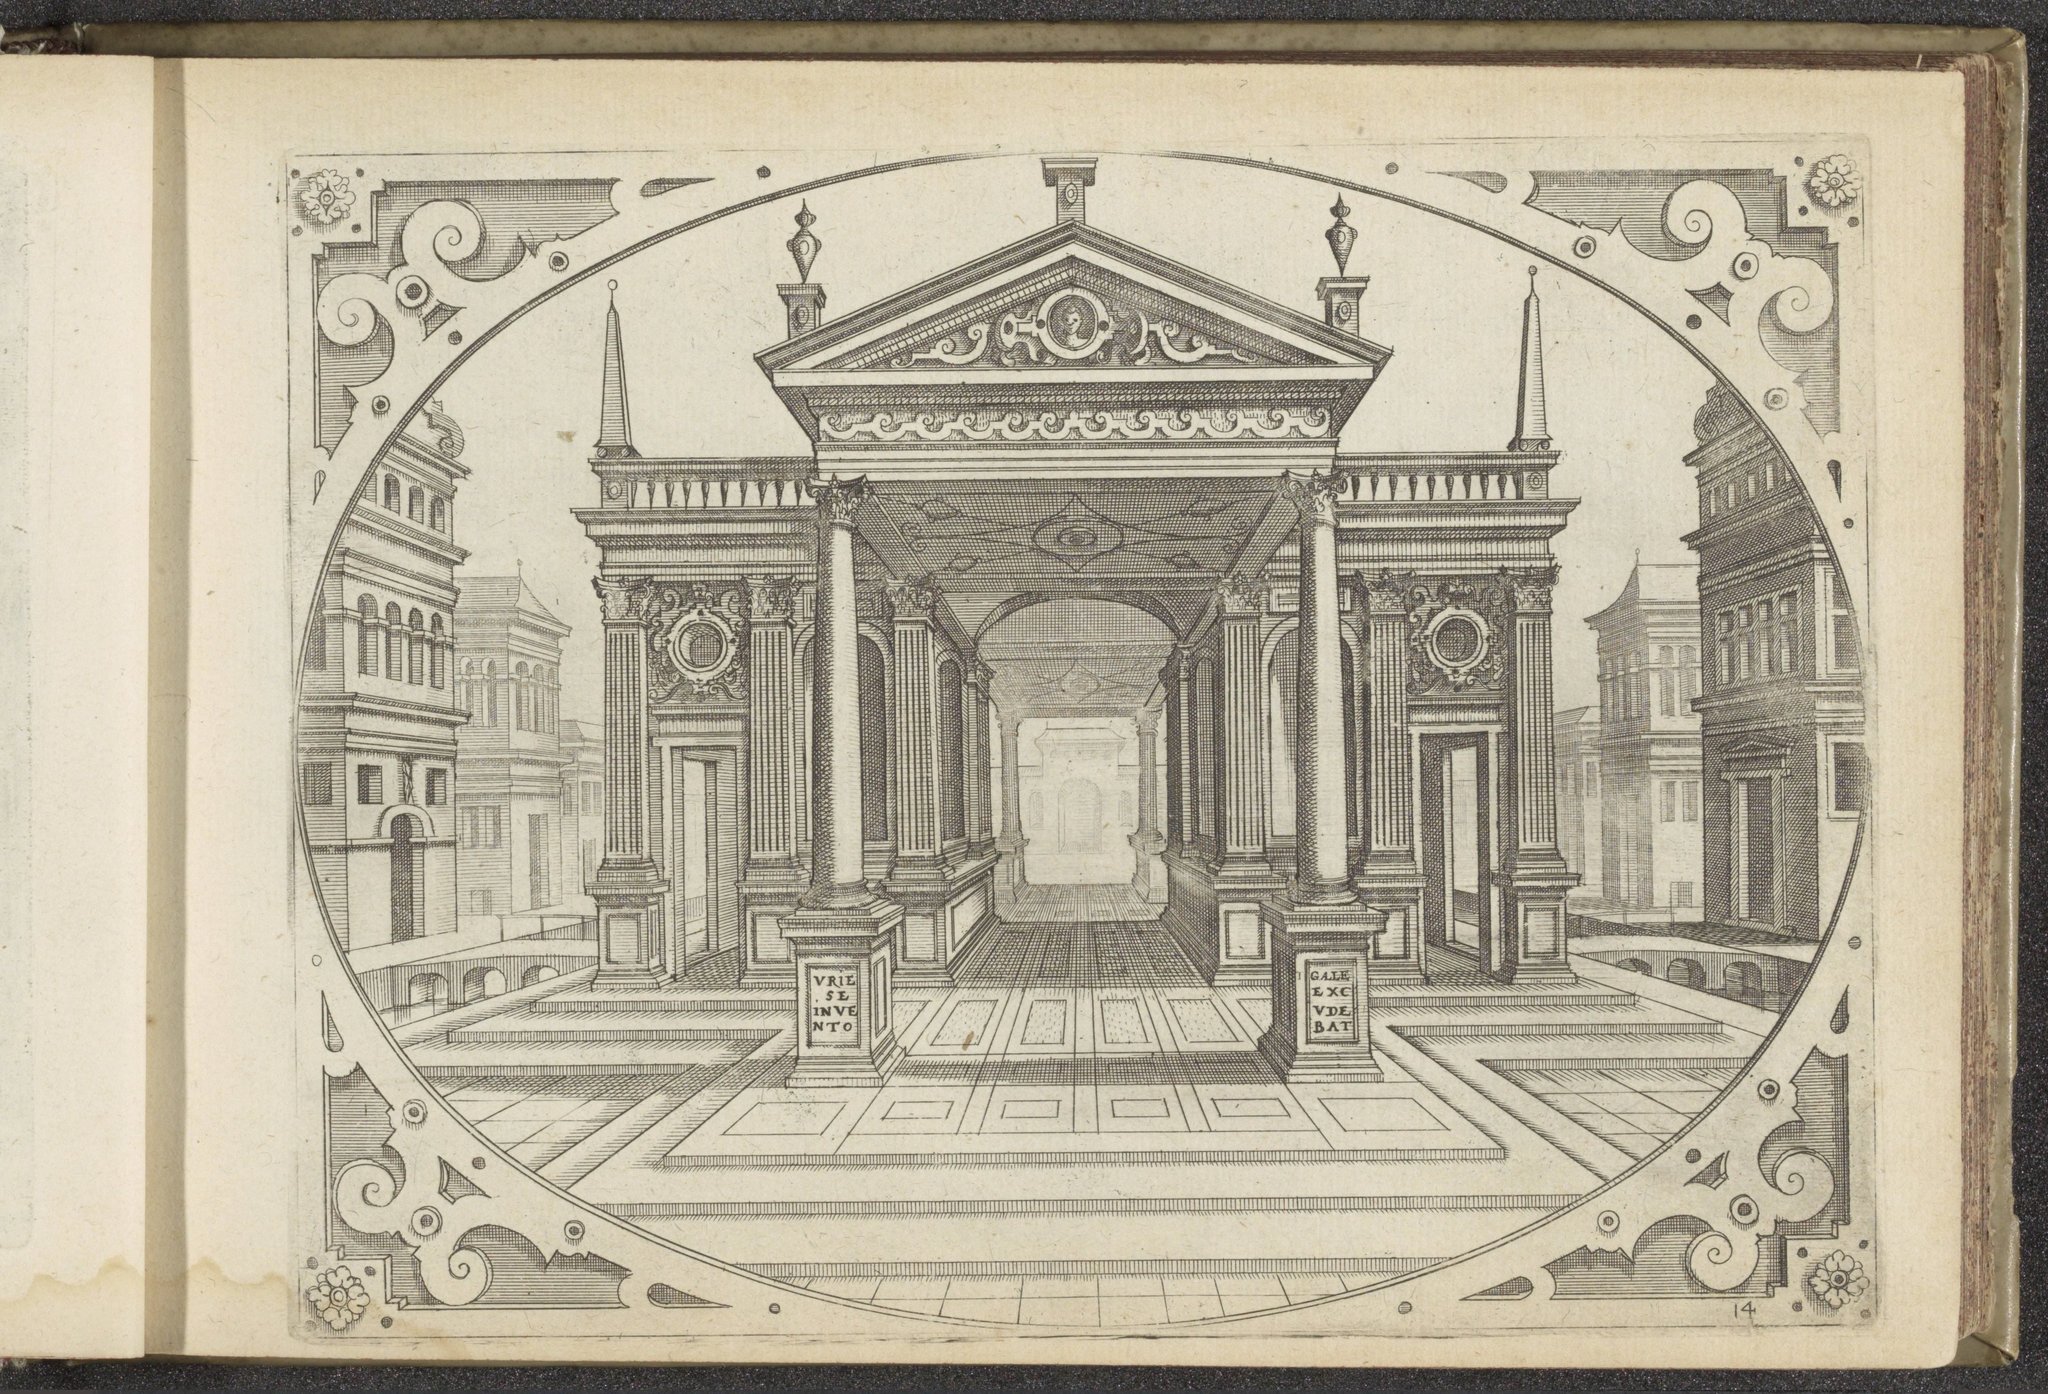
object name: album leaf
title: Variae Architecturae formae (...)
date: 1560-1562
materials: paper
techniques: etching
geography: antwerp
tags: composite order ~ architecture, architectural representations in general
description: Portaal met fronton en zuilen van de composiete orde. Links en rechts gebouwen aan de overzijde van een kanaal. In de hoeken rolwerk. Deze prent maakt deel uit van een album.